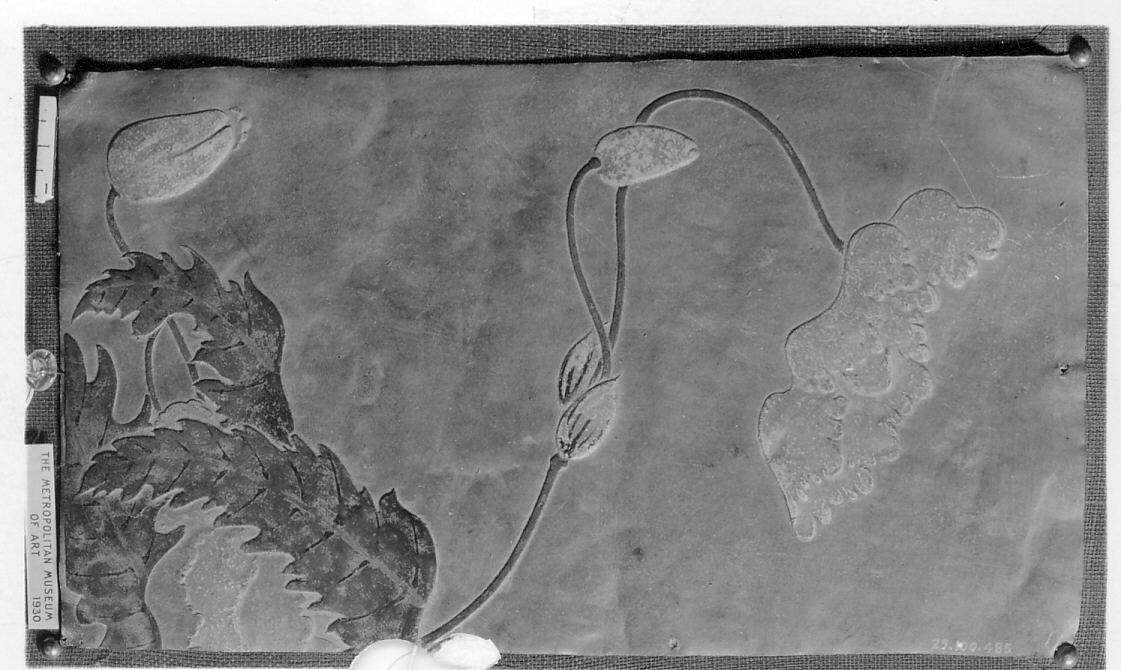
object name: panel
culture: japanese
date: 1801-1900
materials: leather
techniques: lacquer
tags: flowers